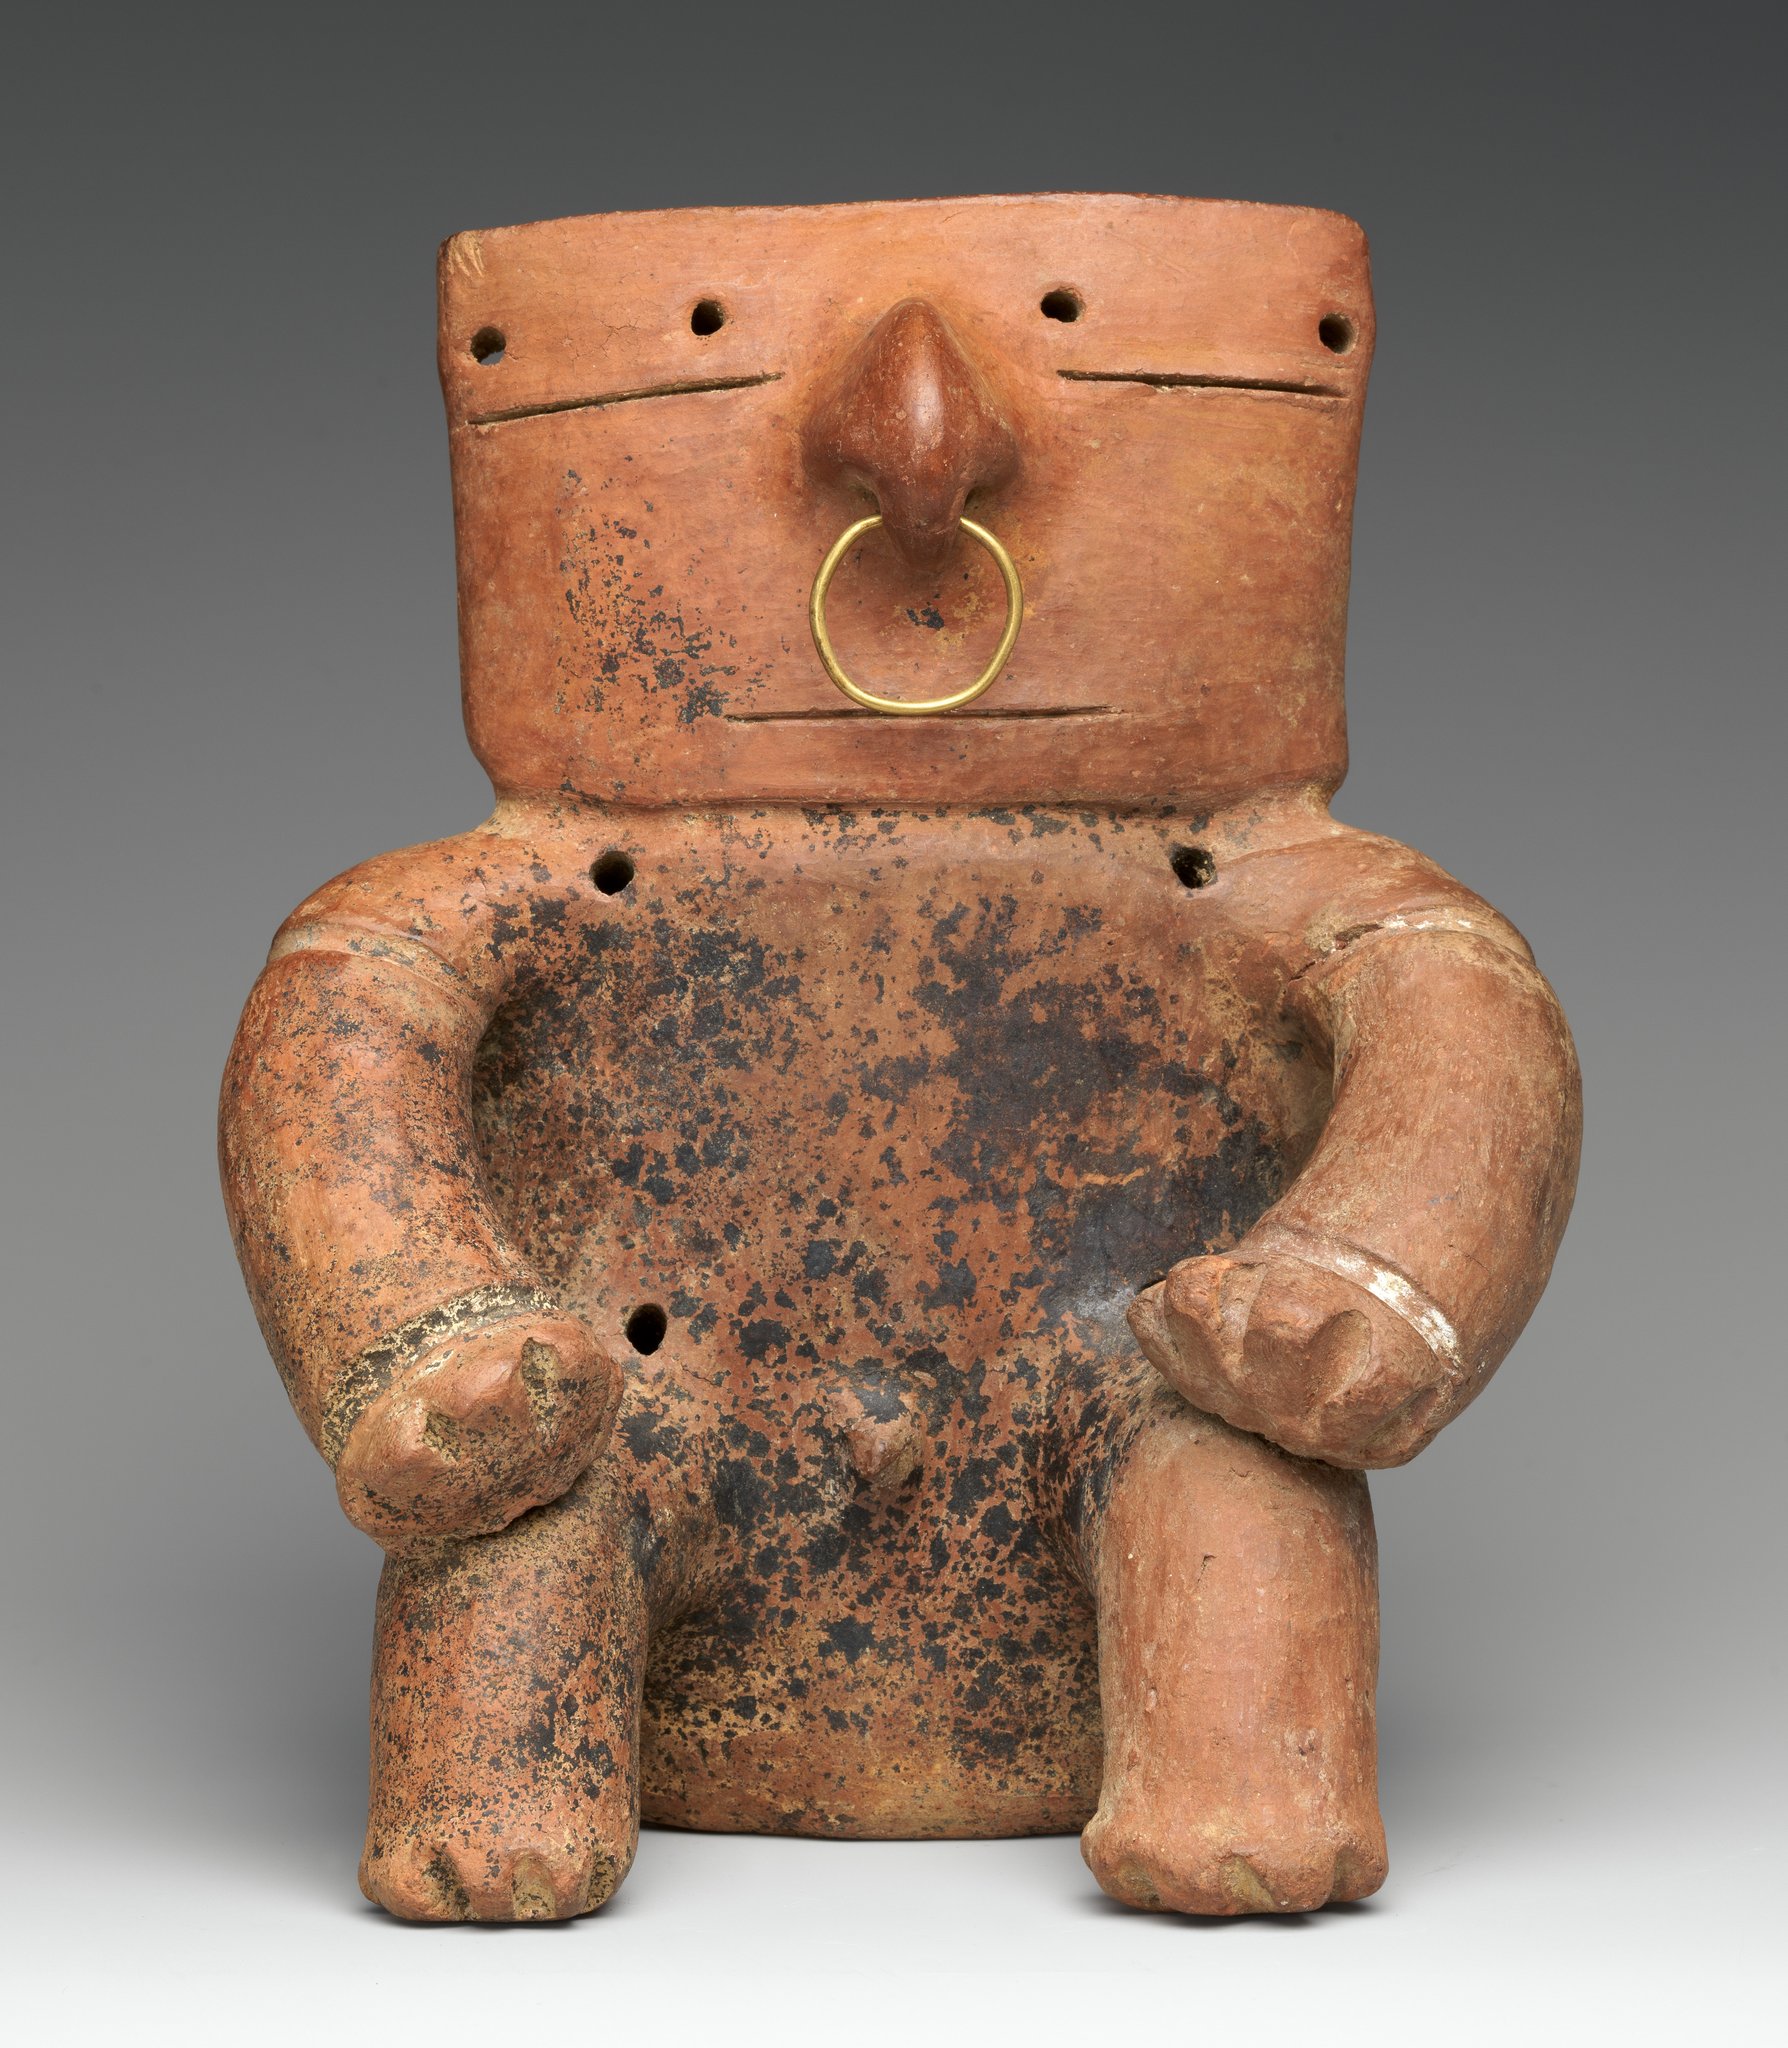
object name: figure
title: Seated Figure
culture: quimbaya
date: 700-1600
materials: ceramic, gold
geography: colombia